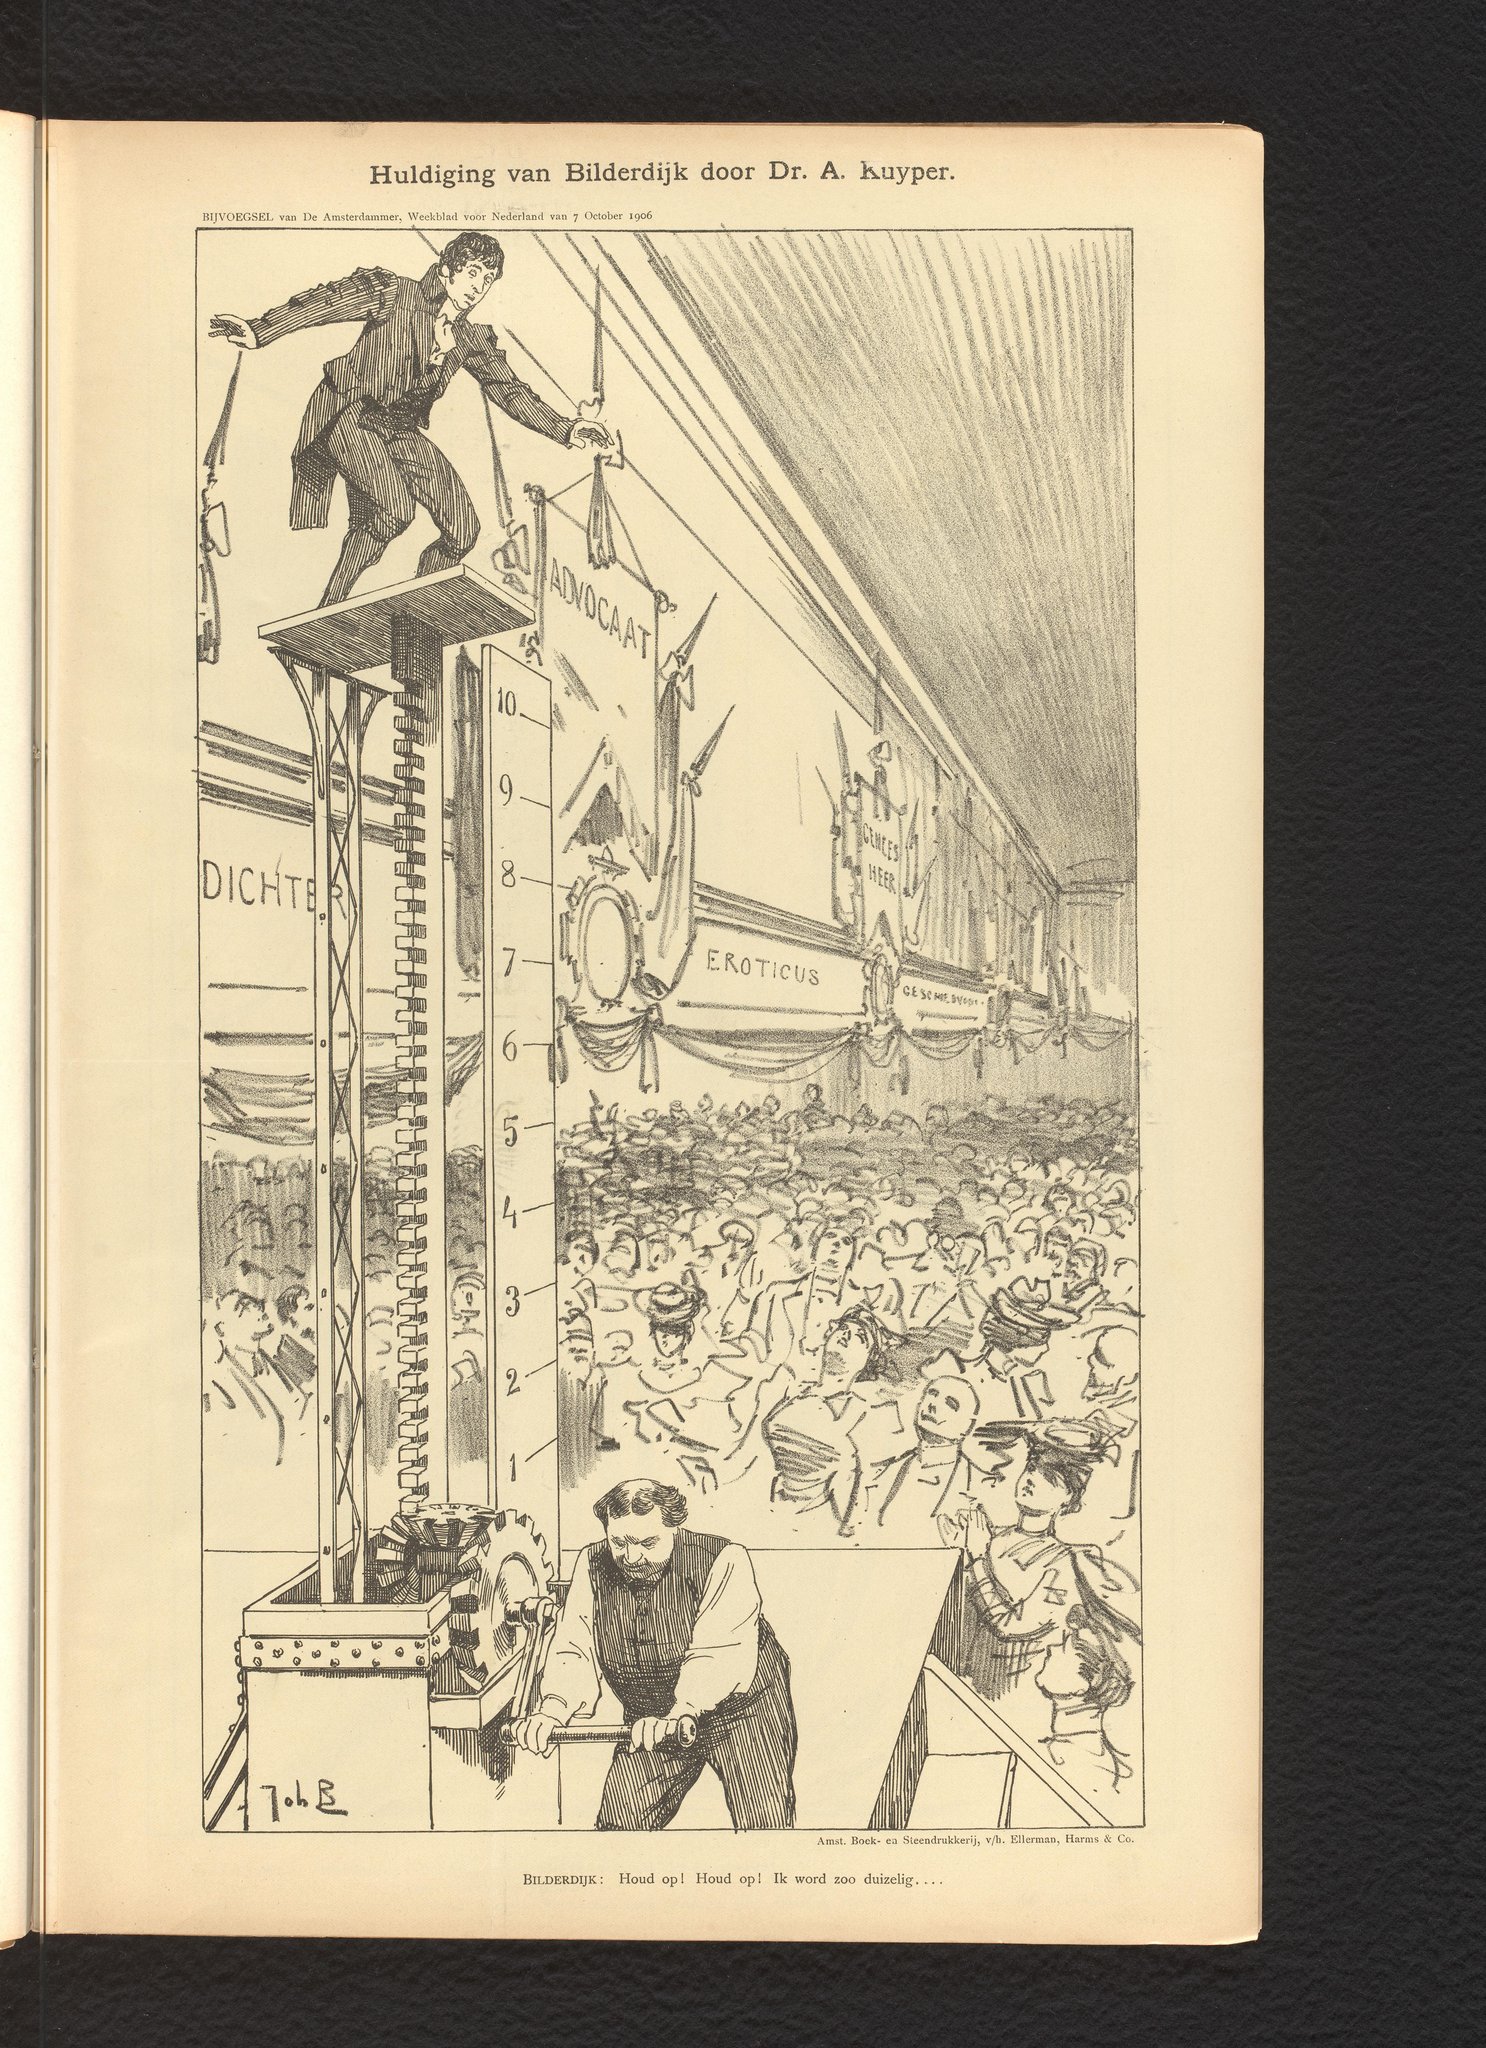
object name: cartoon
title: Huldiging van Bilderdijk door Dr. A. Kuyper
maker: johan braakensiek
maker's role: draughtsman, print maker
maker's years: 1858-1940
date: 1906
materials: paper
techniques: lithograph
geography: amsterdam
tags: amsterdam, haarlem, print maker, draughtsman, willem bilderdijk, the hague, abraham kuyper, political caricatures and satires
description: Ten overstaan van een groot publiek verheft Abraham Kuyper het podium waarop de Willem Bilderdijk staat steeds hoger, tot ongenoegen van de dichter.